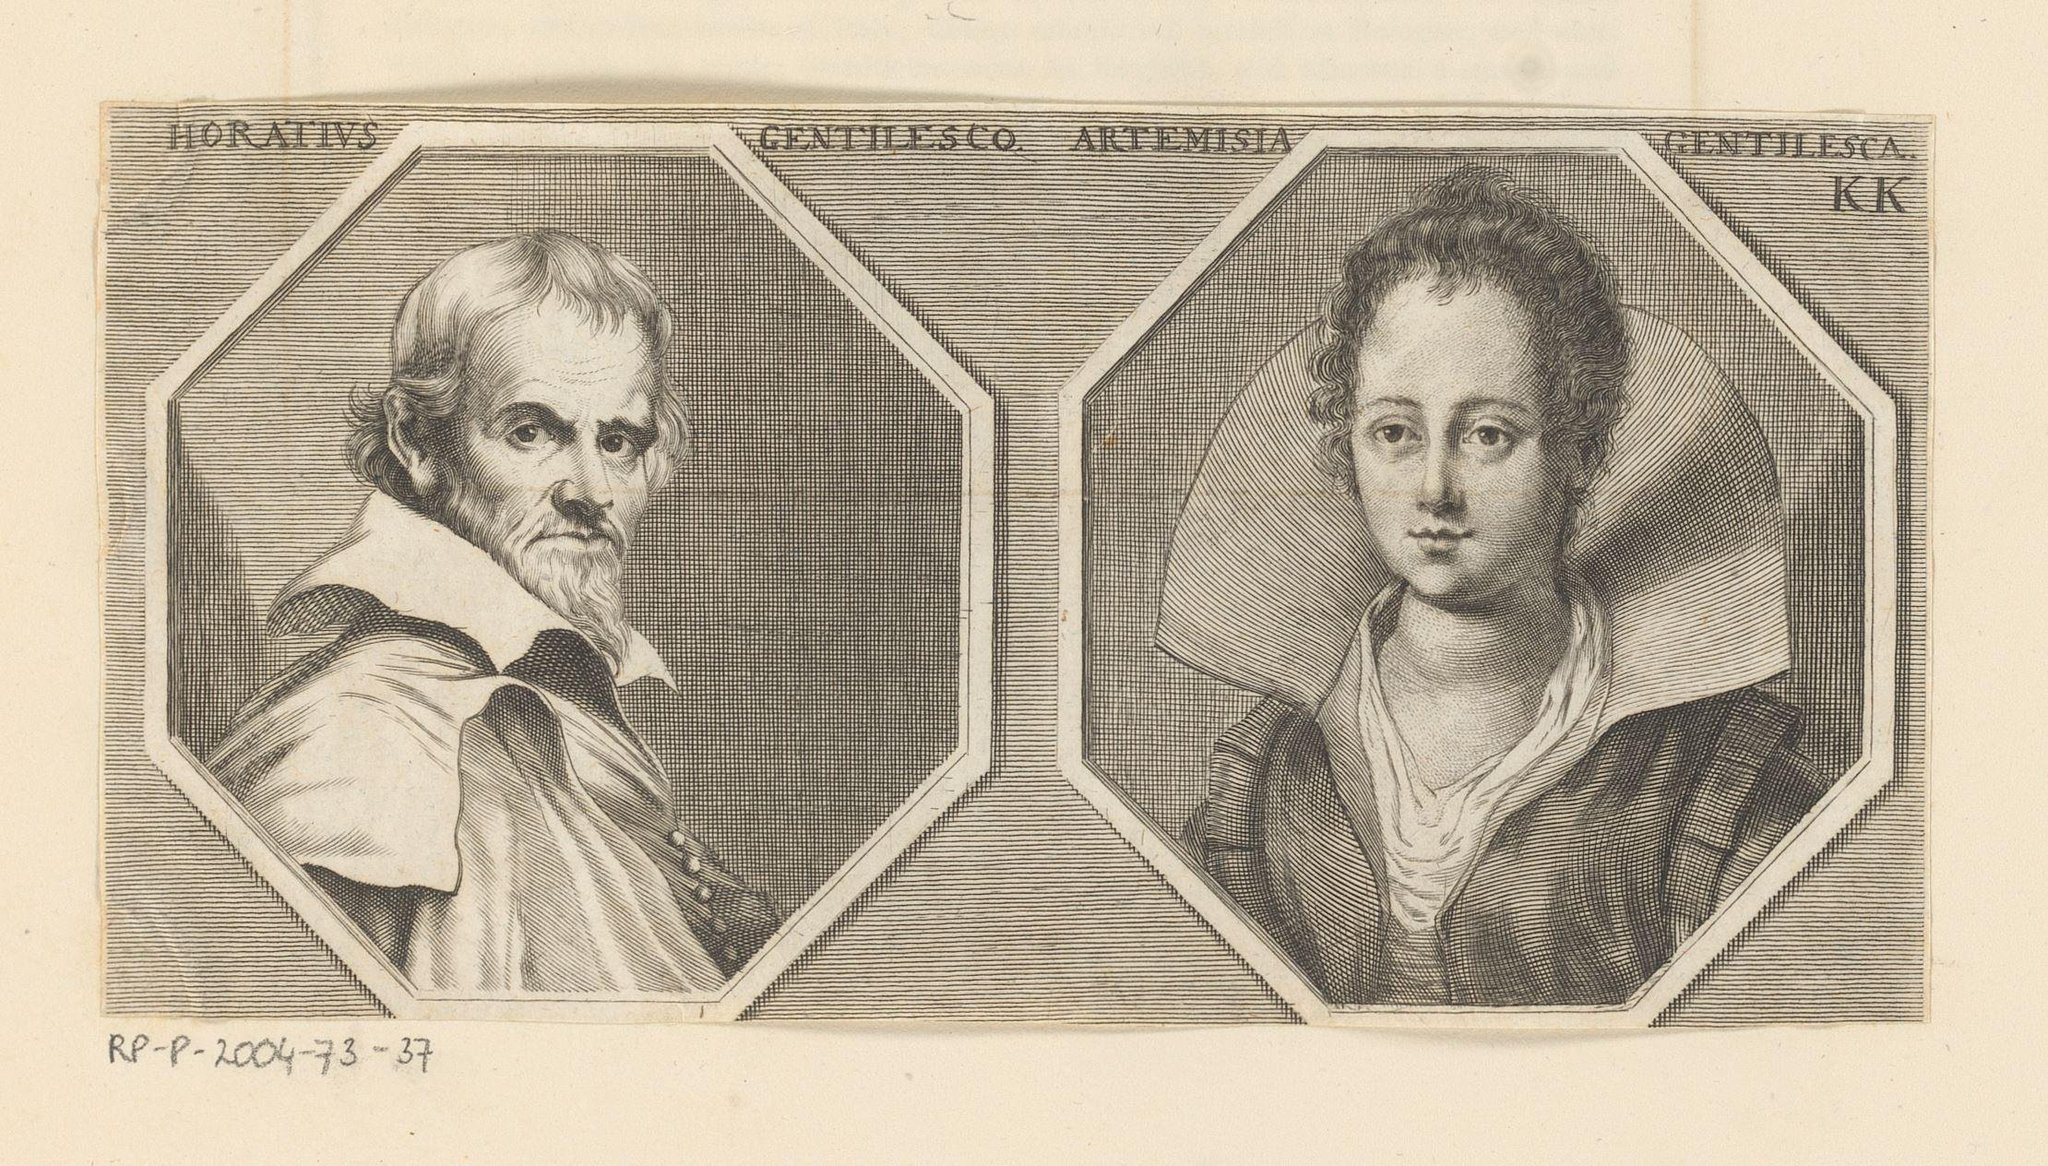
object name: album leaf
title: Horatius Gentilesco / Artemisia Gentilesca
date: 1675-1679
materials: paper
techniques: engraving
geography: nuremberg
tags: naples, painter, artemisia gentileschi, orazio gentileschi, historical persons, portrait, self-portrait of painter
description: Prent uit: Sandrart, Joachim von. Teutsche Academie der Edlen Bau- Bild- und Mahlerey-Künste (...). Neurenberg: Jakob von Sandrart, [1675-1679], dl. 1, p. 298, afb. KK. De samensteller heeft deze prent in het album geplakt als illustratie bij: Pilkington, Matthew en Johann Heinrich Füssli. A dictionary of painters, from the revival of the art to the present period. 4 dln. Londen: John Crowder, 1805, dl. 2, p. 217.